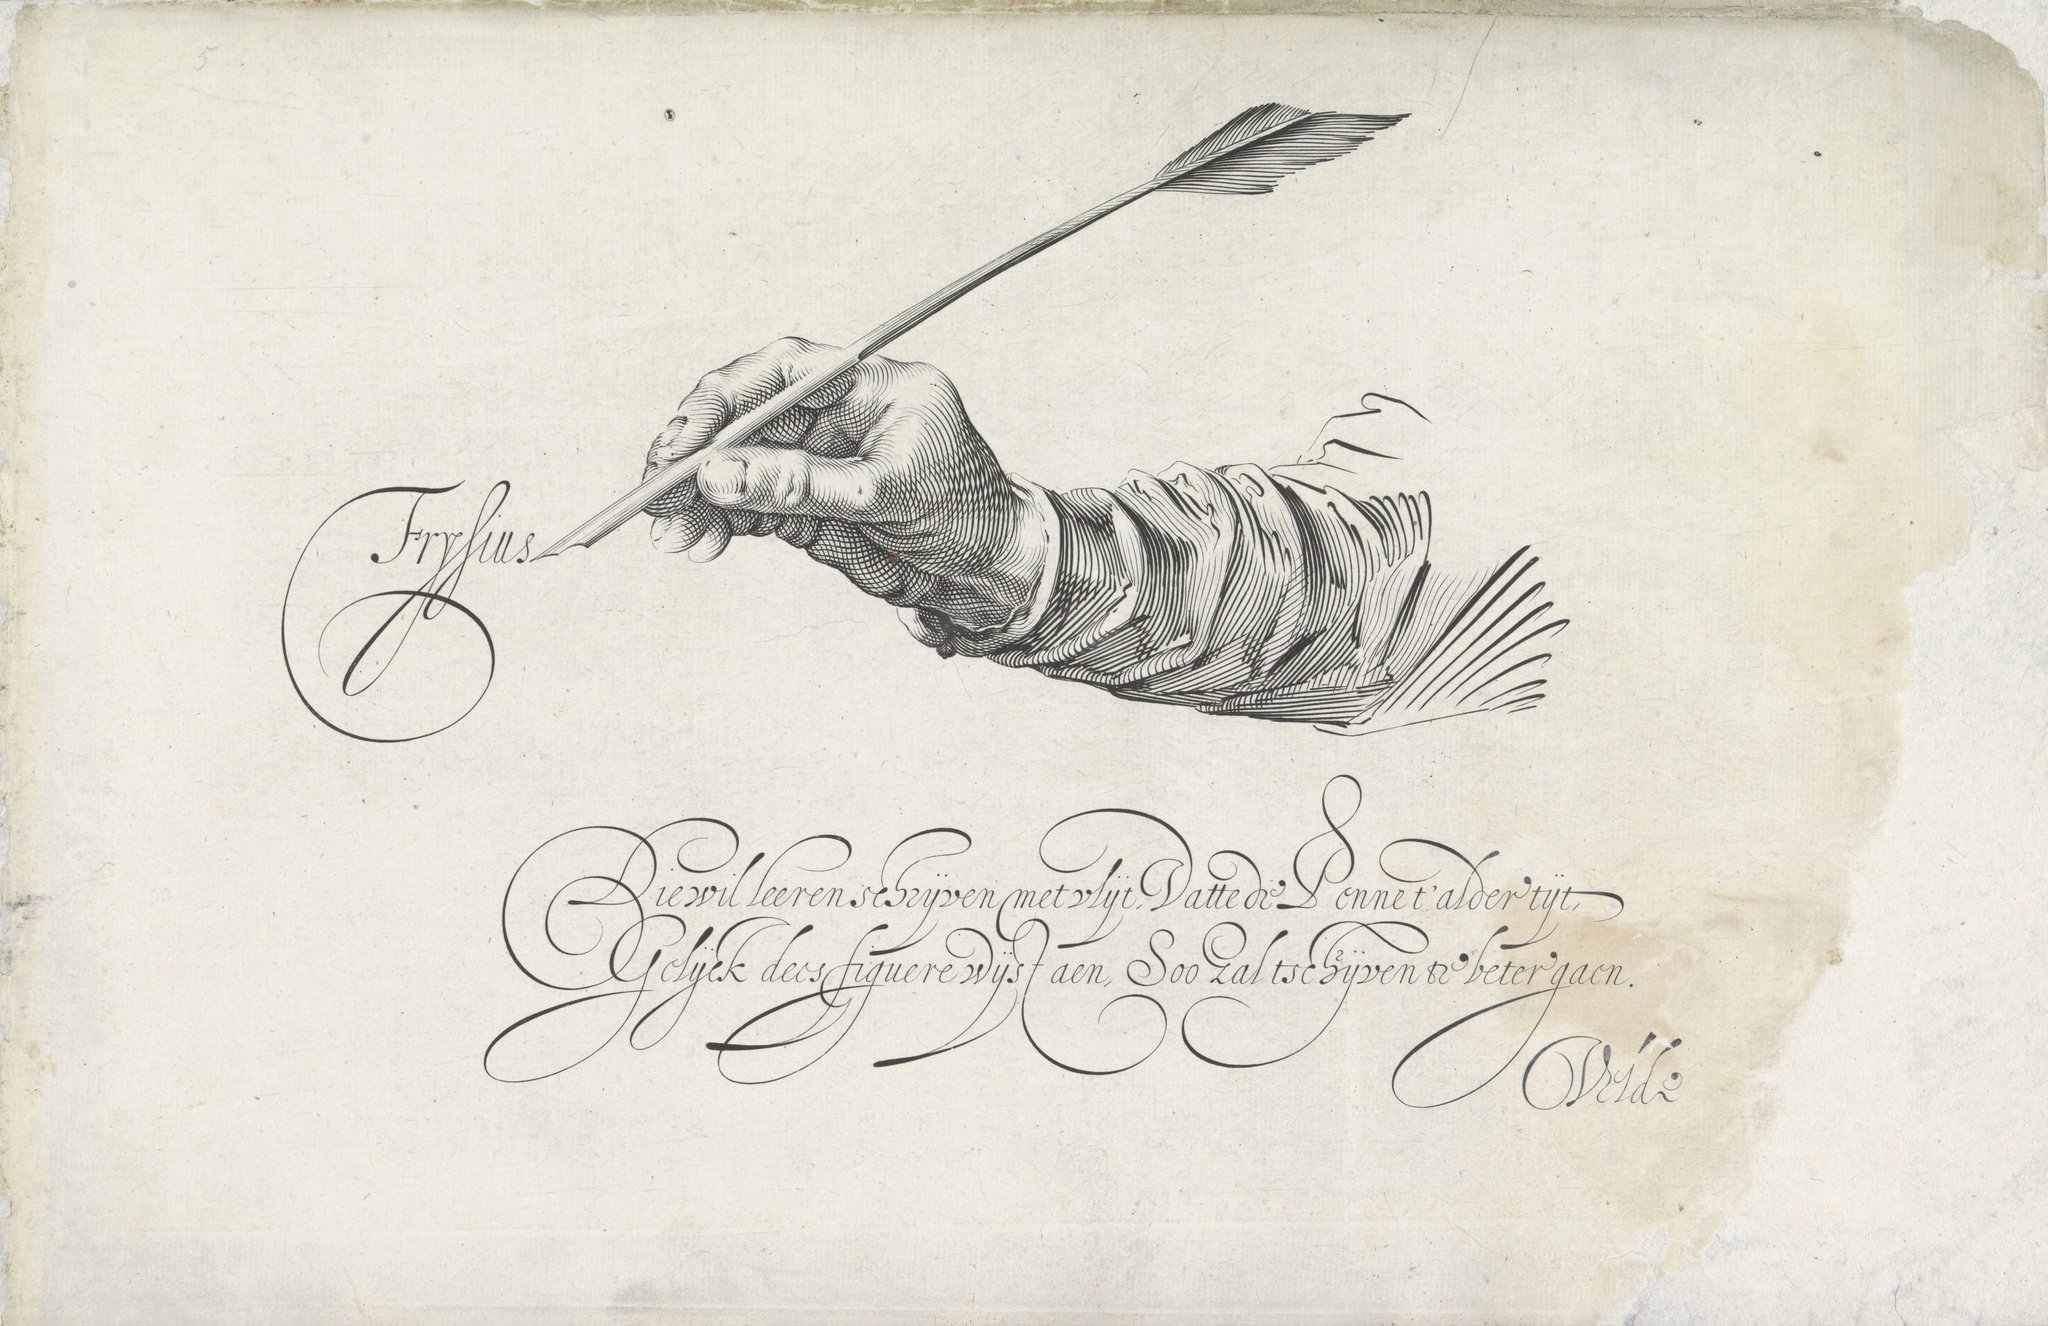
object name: print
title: Rechterhand met ganzenpen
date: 1605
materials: paper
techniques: engraving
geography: haarlem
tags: handwriting, writing as activity, quill, calligraphy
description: Rechterhand met ganzenpen, Frysius schrijvend. Met tweeregelig onderschrift in het Frans: Die wil leeren schrijven met vlijt ... De prent maakt deel uit van een album.